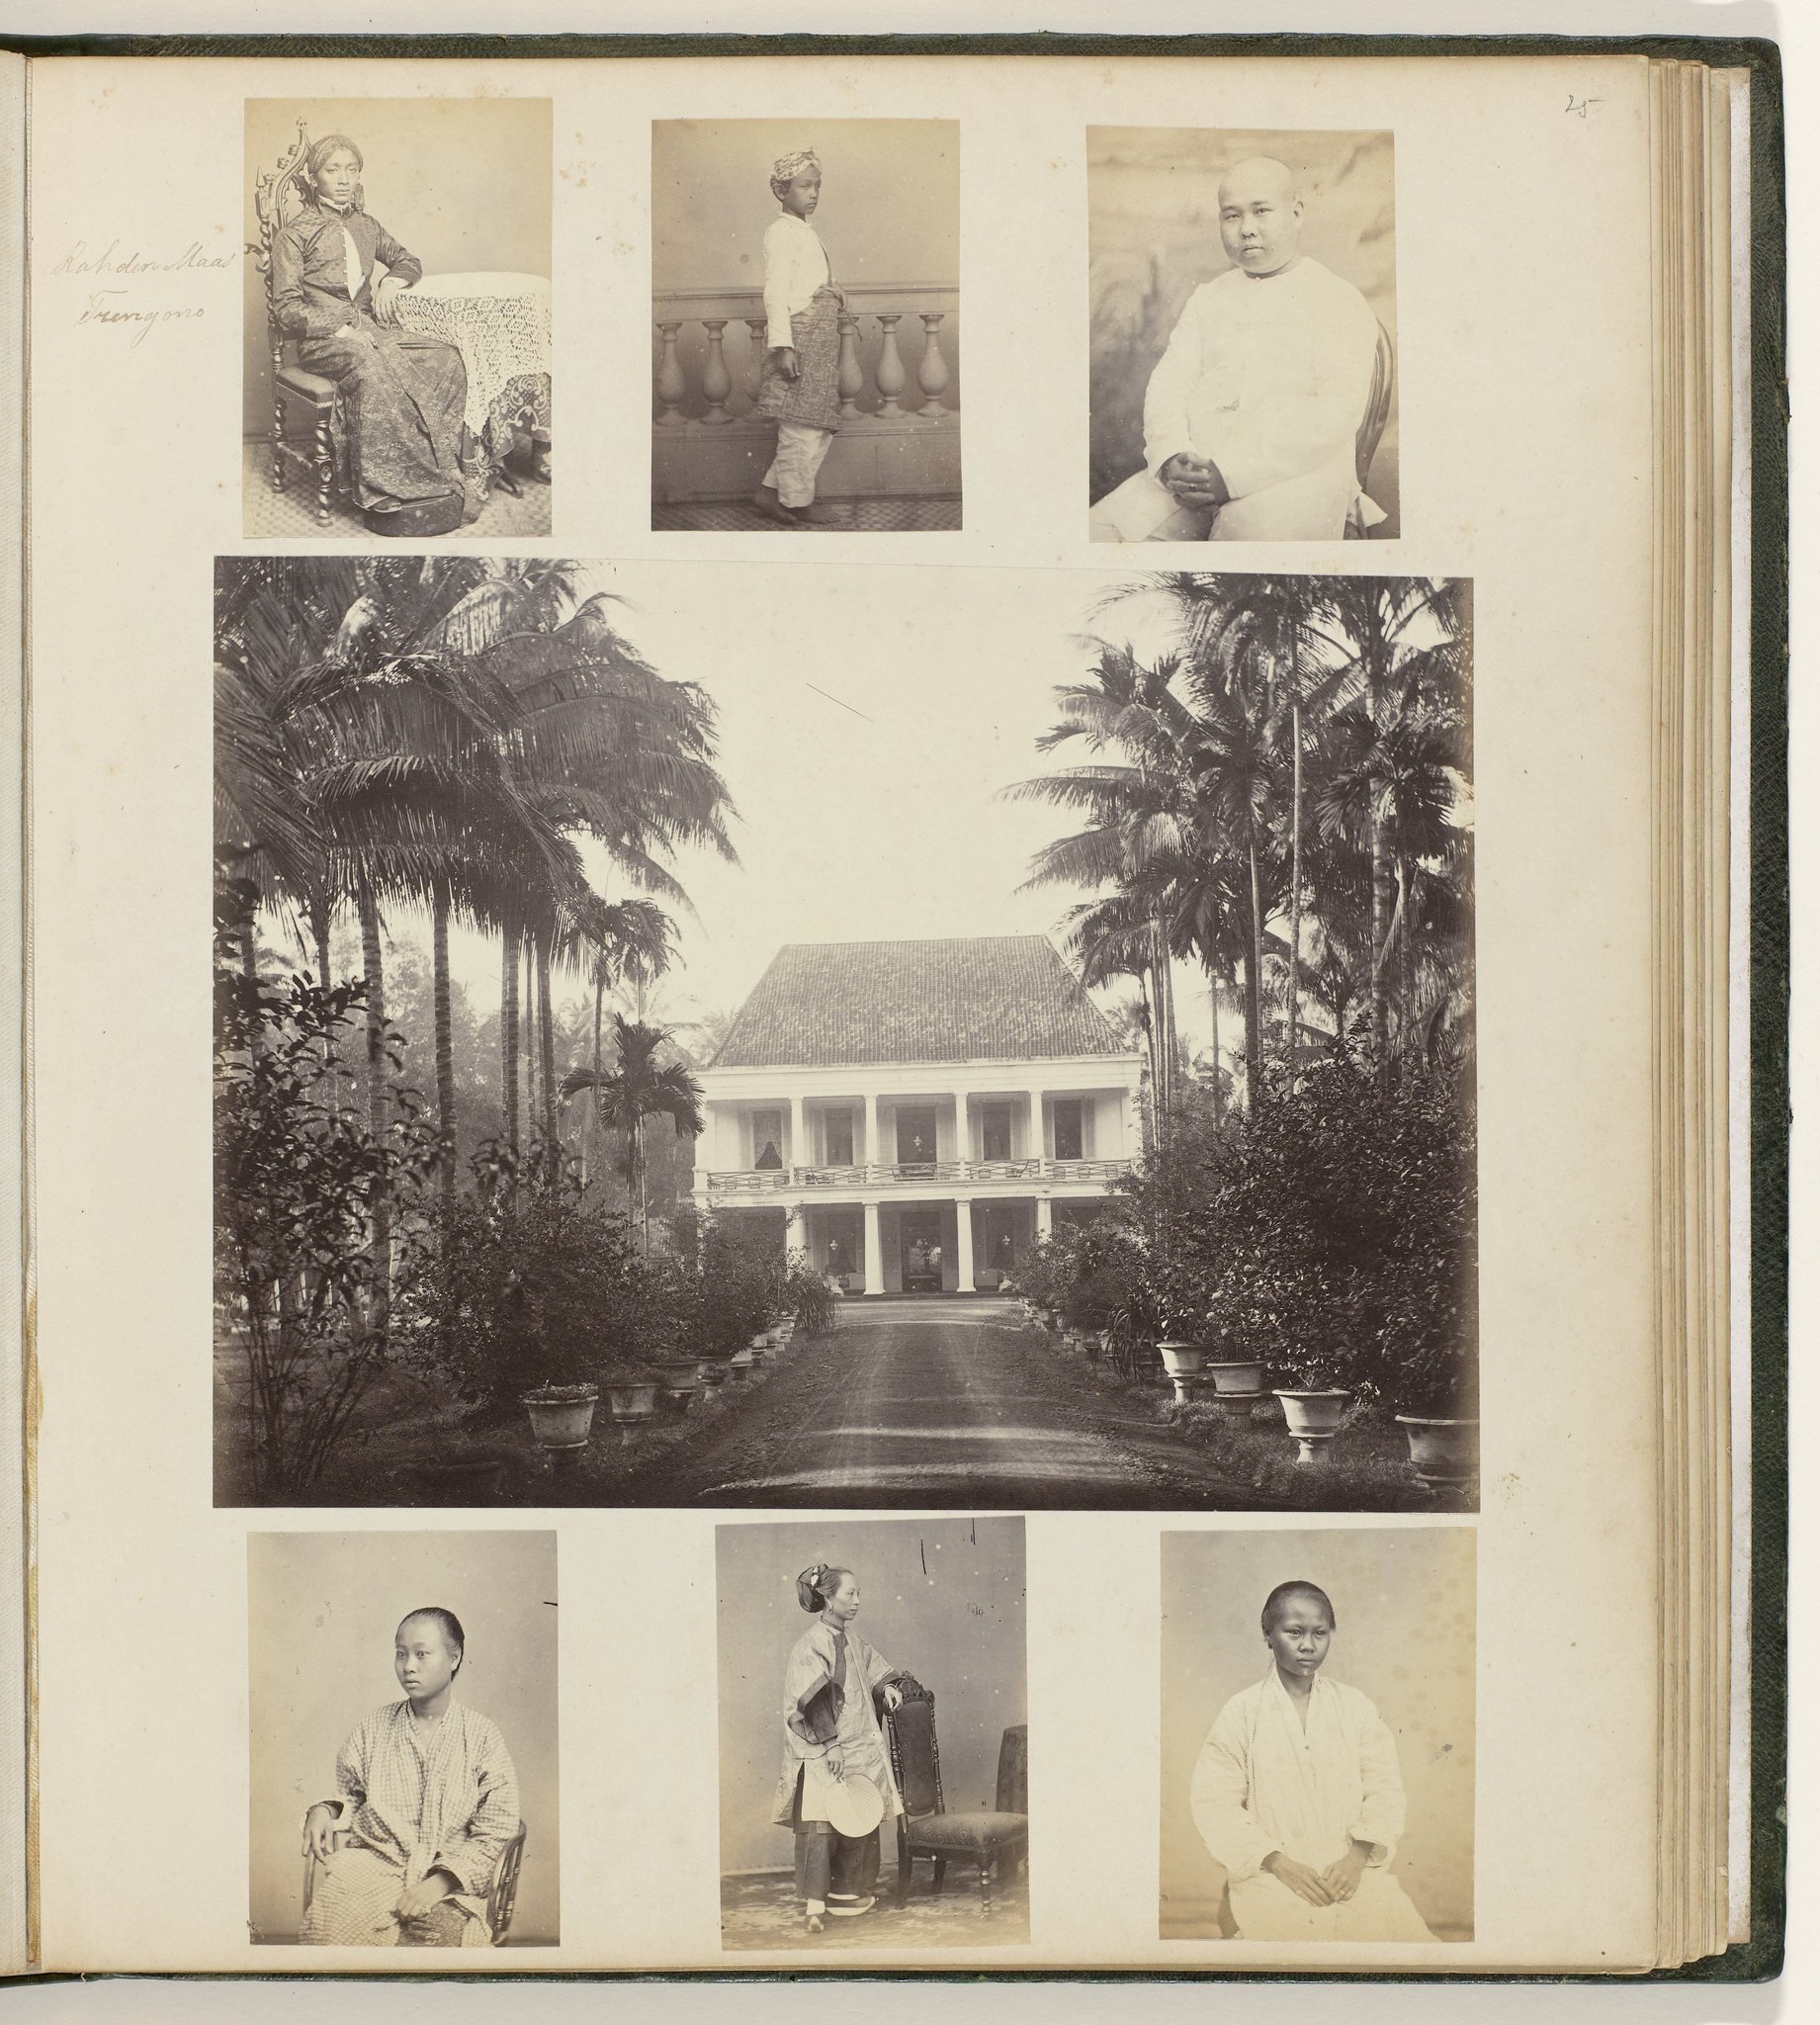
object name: album leaf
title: Woonhuis en zes portretten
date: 1863-1866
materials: cardboard, photographic support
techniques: albumen print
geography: batavia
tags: historical persons not known by name - bb - woman, detached house in city, historical persons not known by name, batavia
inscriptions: inscription: ‘Rahden Maas Trengono’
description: Albumblad met zeven foto's. Centraal een gezicht op een woonhuis met oprijlaan waarlangs potten met planten staan. Bovenaan drie portretten, links portret van Raden Mas Trengono. Onderaan drie portretten van vrouwen. Onderdeel van het tweede groene fotoalbum met foto's van Java, uit het bezit van apotheker Specht-Grijp, die in 1865 vanuit Batavia naar Nederland terugkeerde.